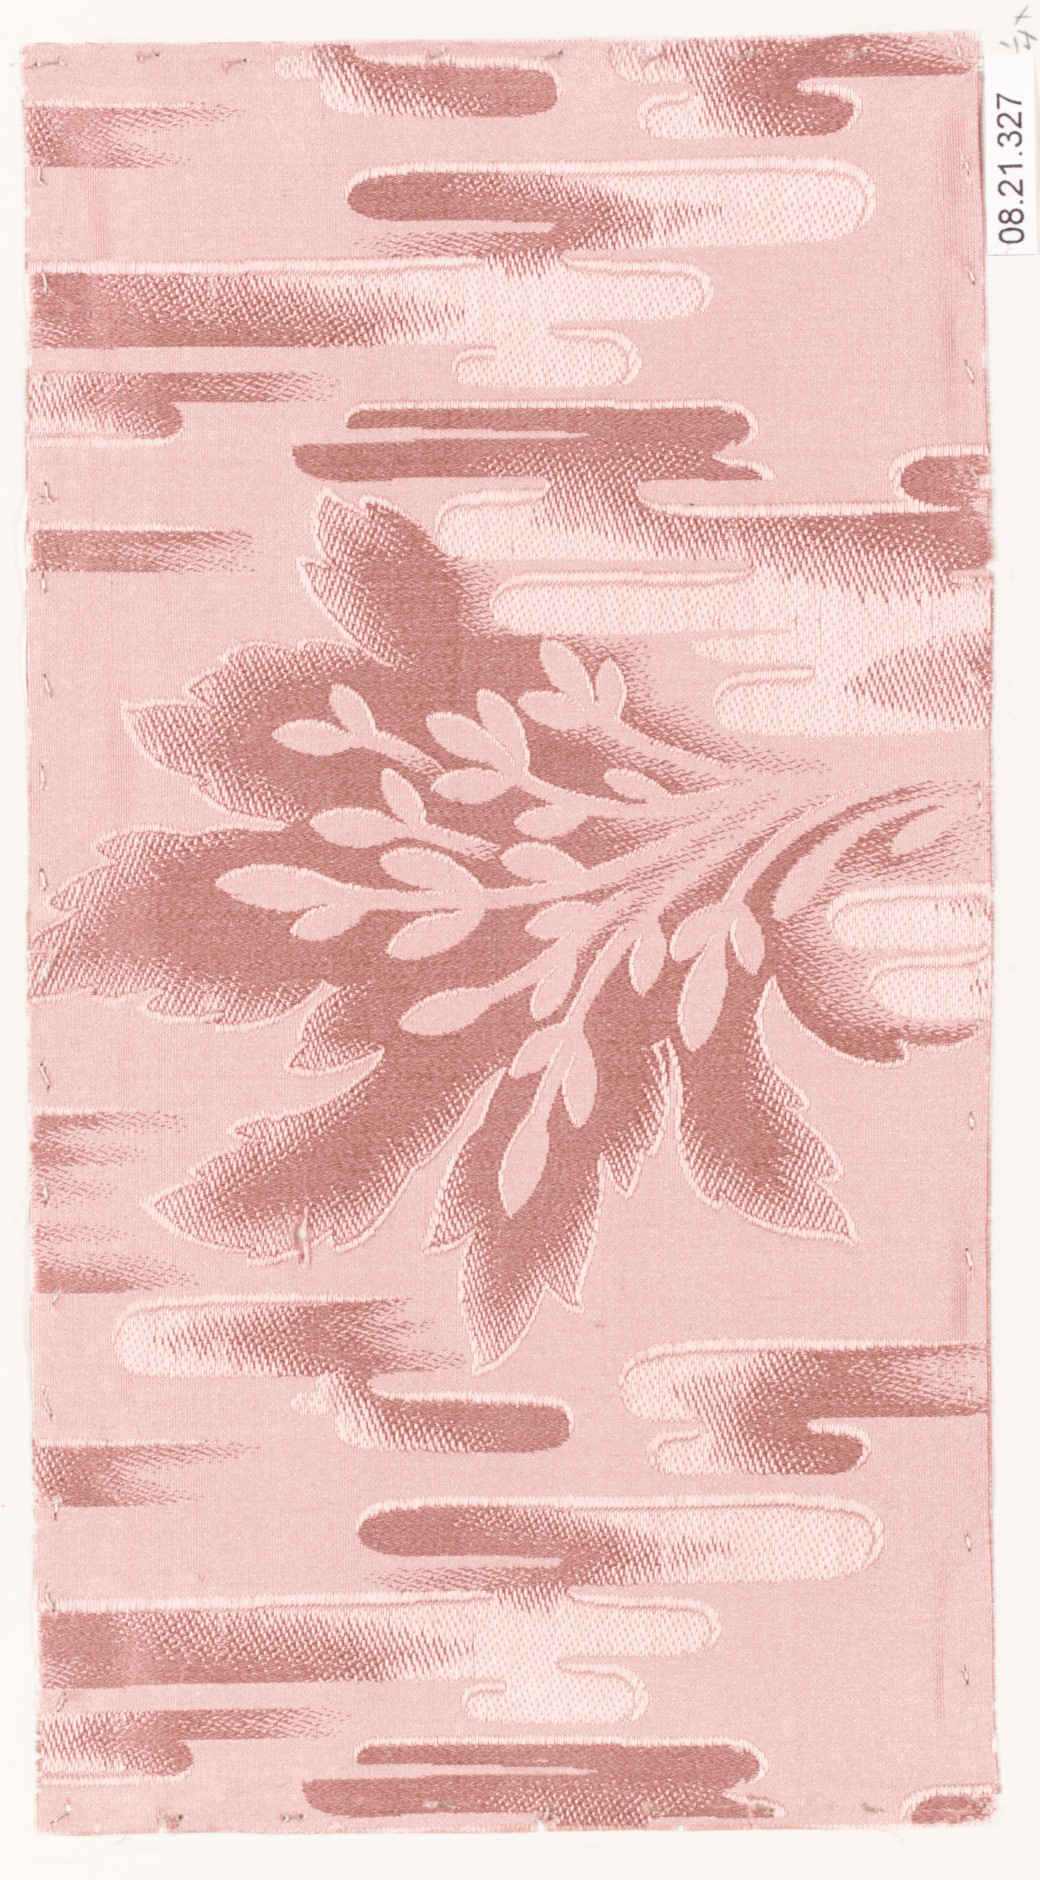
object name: textile sample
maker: Anonymous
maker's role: designer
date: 1900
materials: silk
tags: leaves